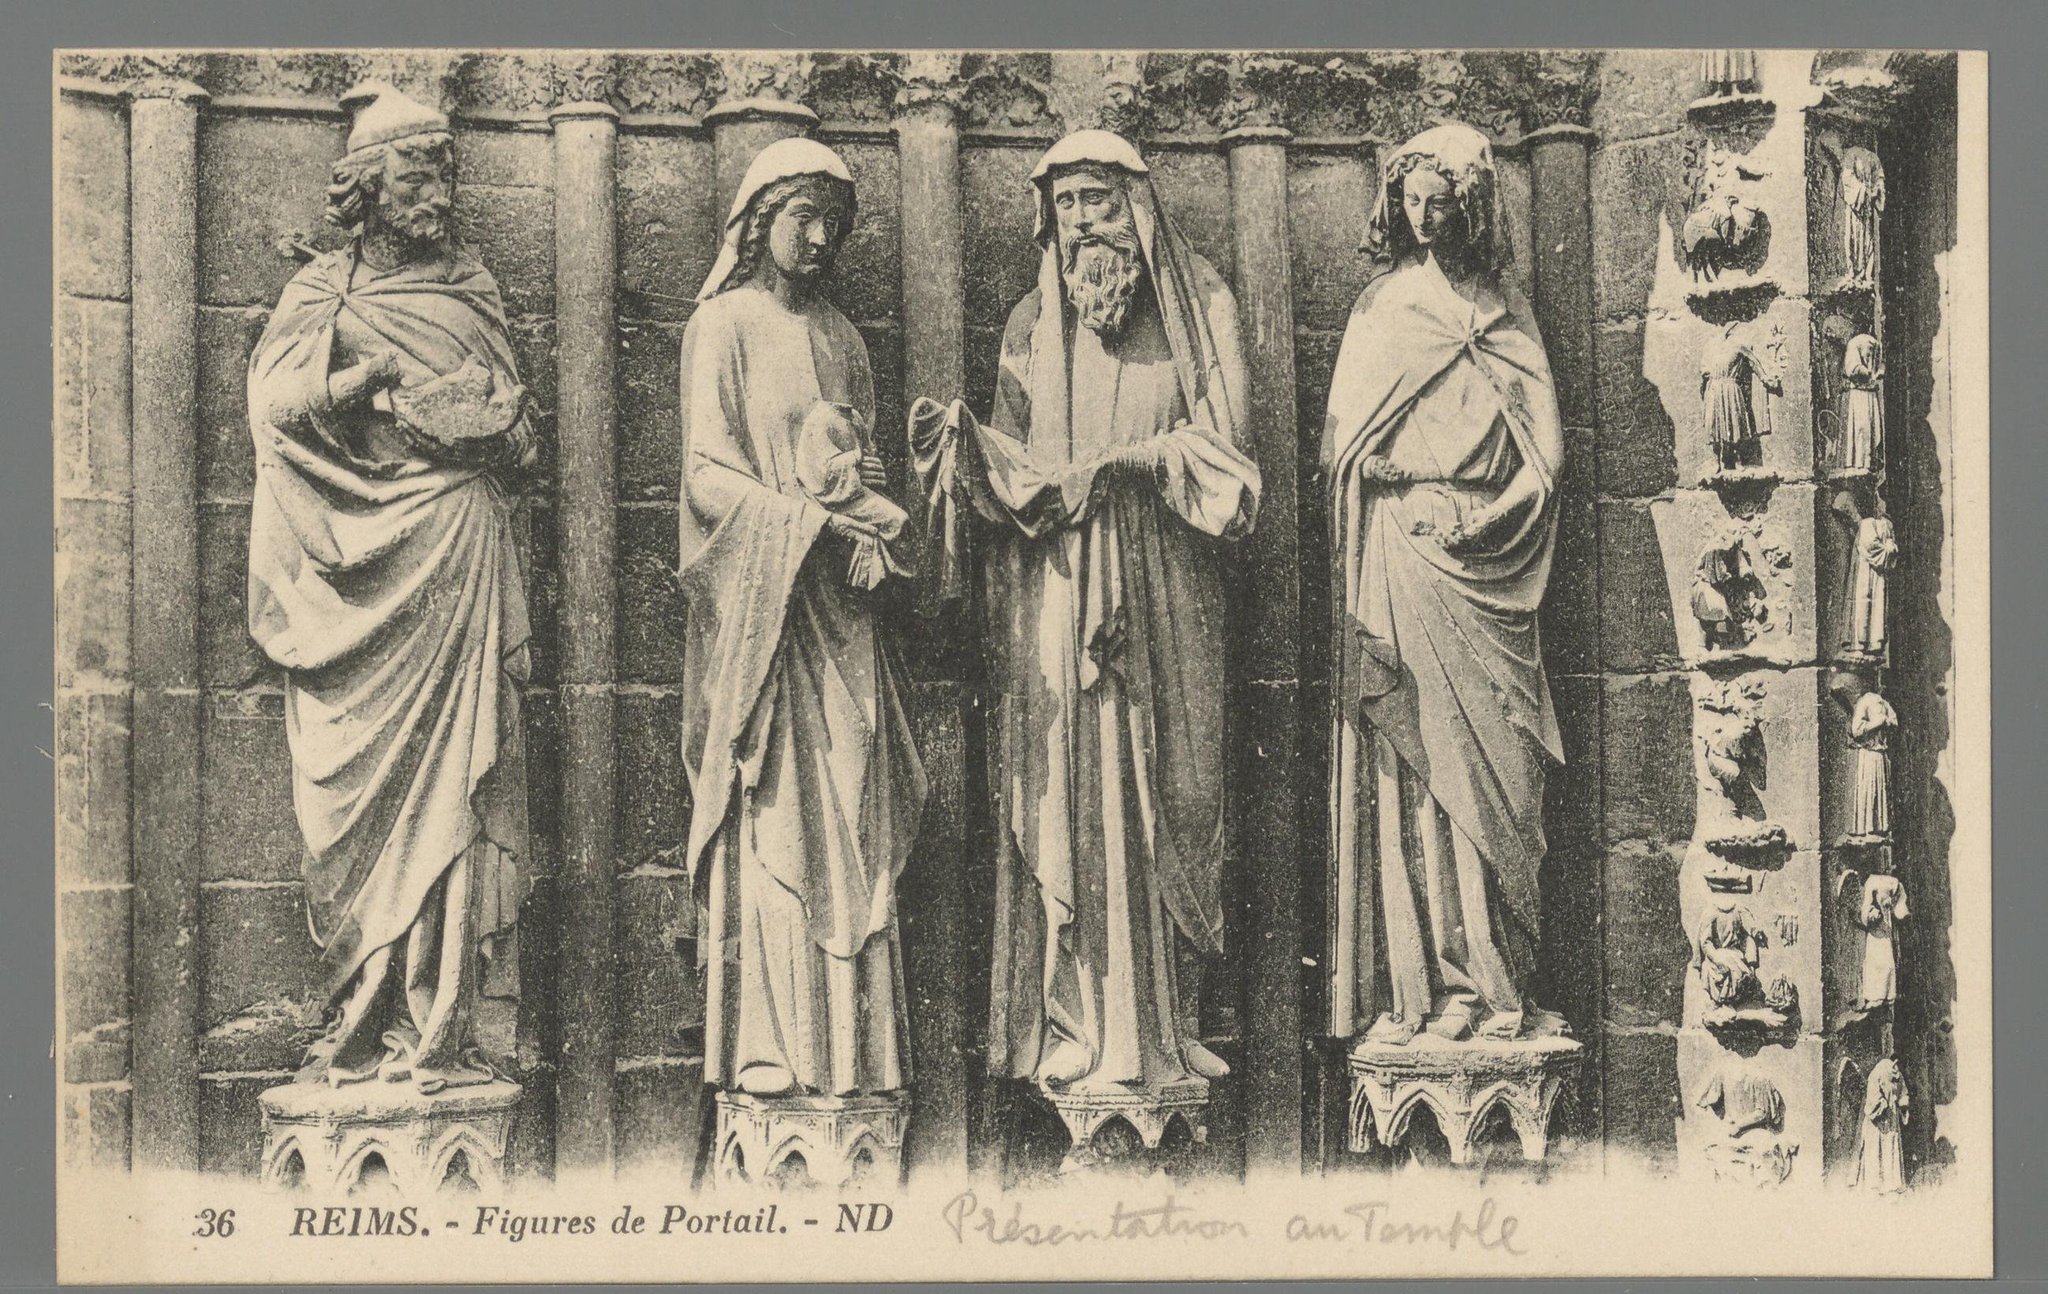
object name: photomechanical print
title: Reims - Figures de Portail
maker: Anonymous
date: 1903-1932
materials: cardboard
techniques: photograph, writing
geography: reims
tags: church (exterior), statues, paintings, etc. ~ objects of worship in roman religion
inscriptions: collector's mark: ‘AFE v S’